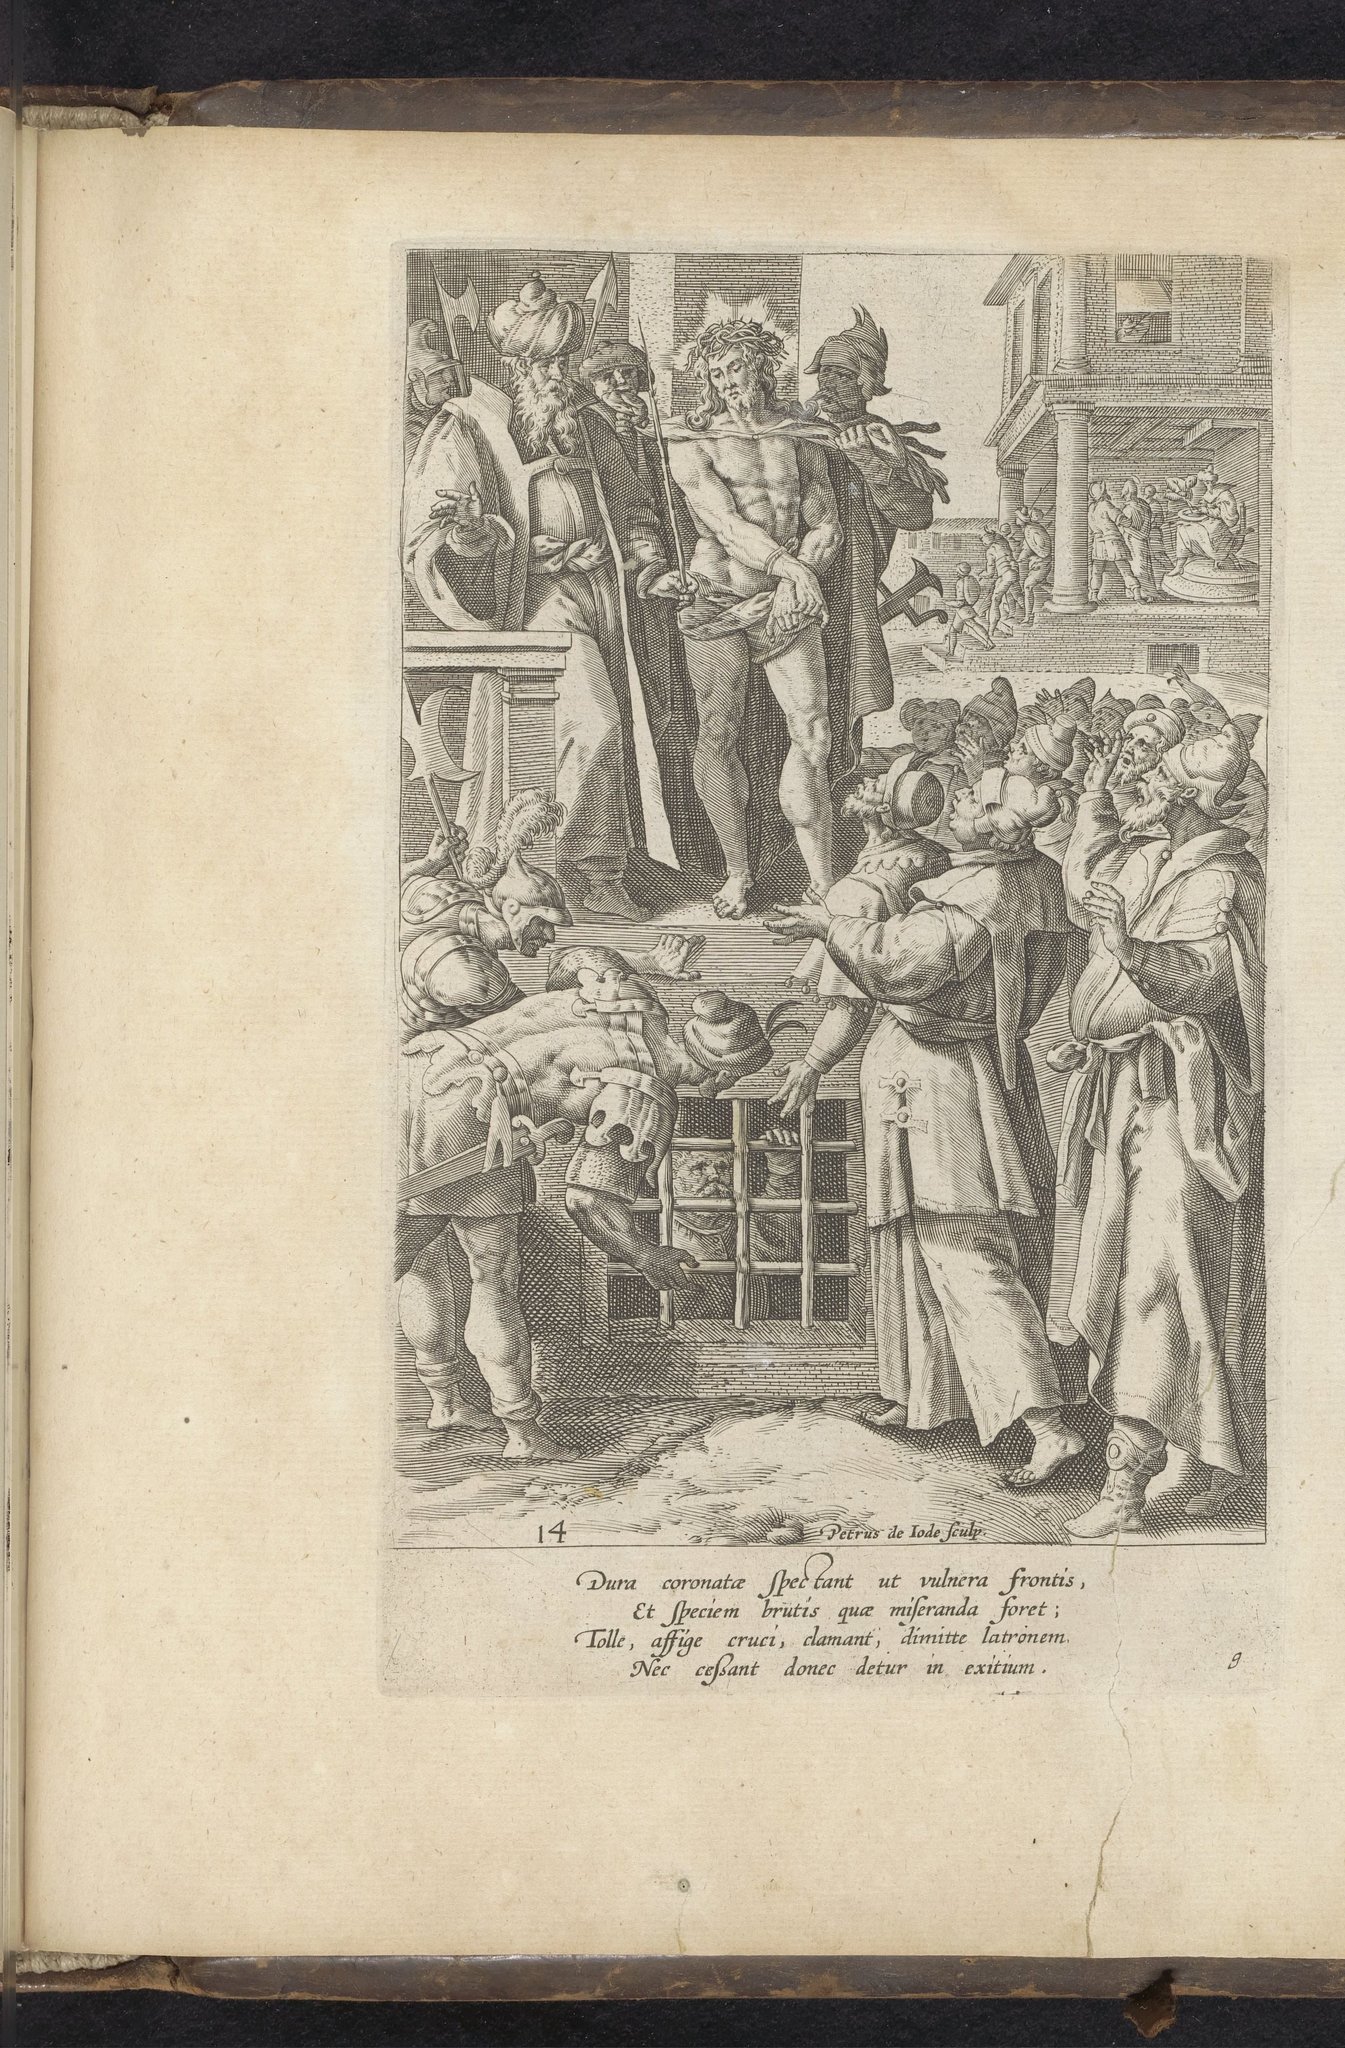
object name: album leaf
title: Christus aan het volk getoond (Ecce Homo)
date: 1585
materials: paper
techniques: engraving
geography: amsterdam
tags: pilate showing christ to the people, 'ostentatio christi', 'ecce homo' (john 19:4-6)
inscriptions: number: ‘139’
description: Pilatus toont Christus aan het volk. Onder het bordes waarop hij staat is een getralied venster te zien waarachter de gevangene Barabbas. Het volk roept op de gevangene vrij te laten. Onder de voorstelling een vierregelig vers in het Latijn. Rechtsonder de letter: g. Deze prent maakt deel uit van een album.